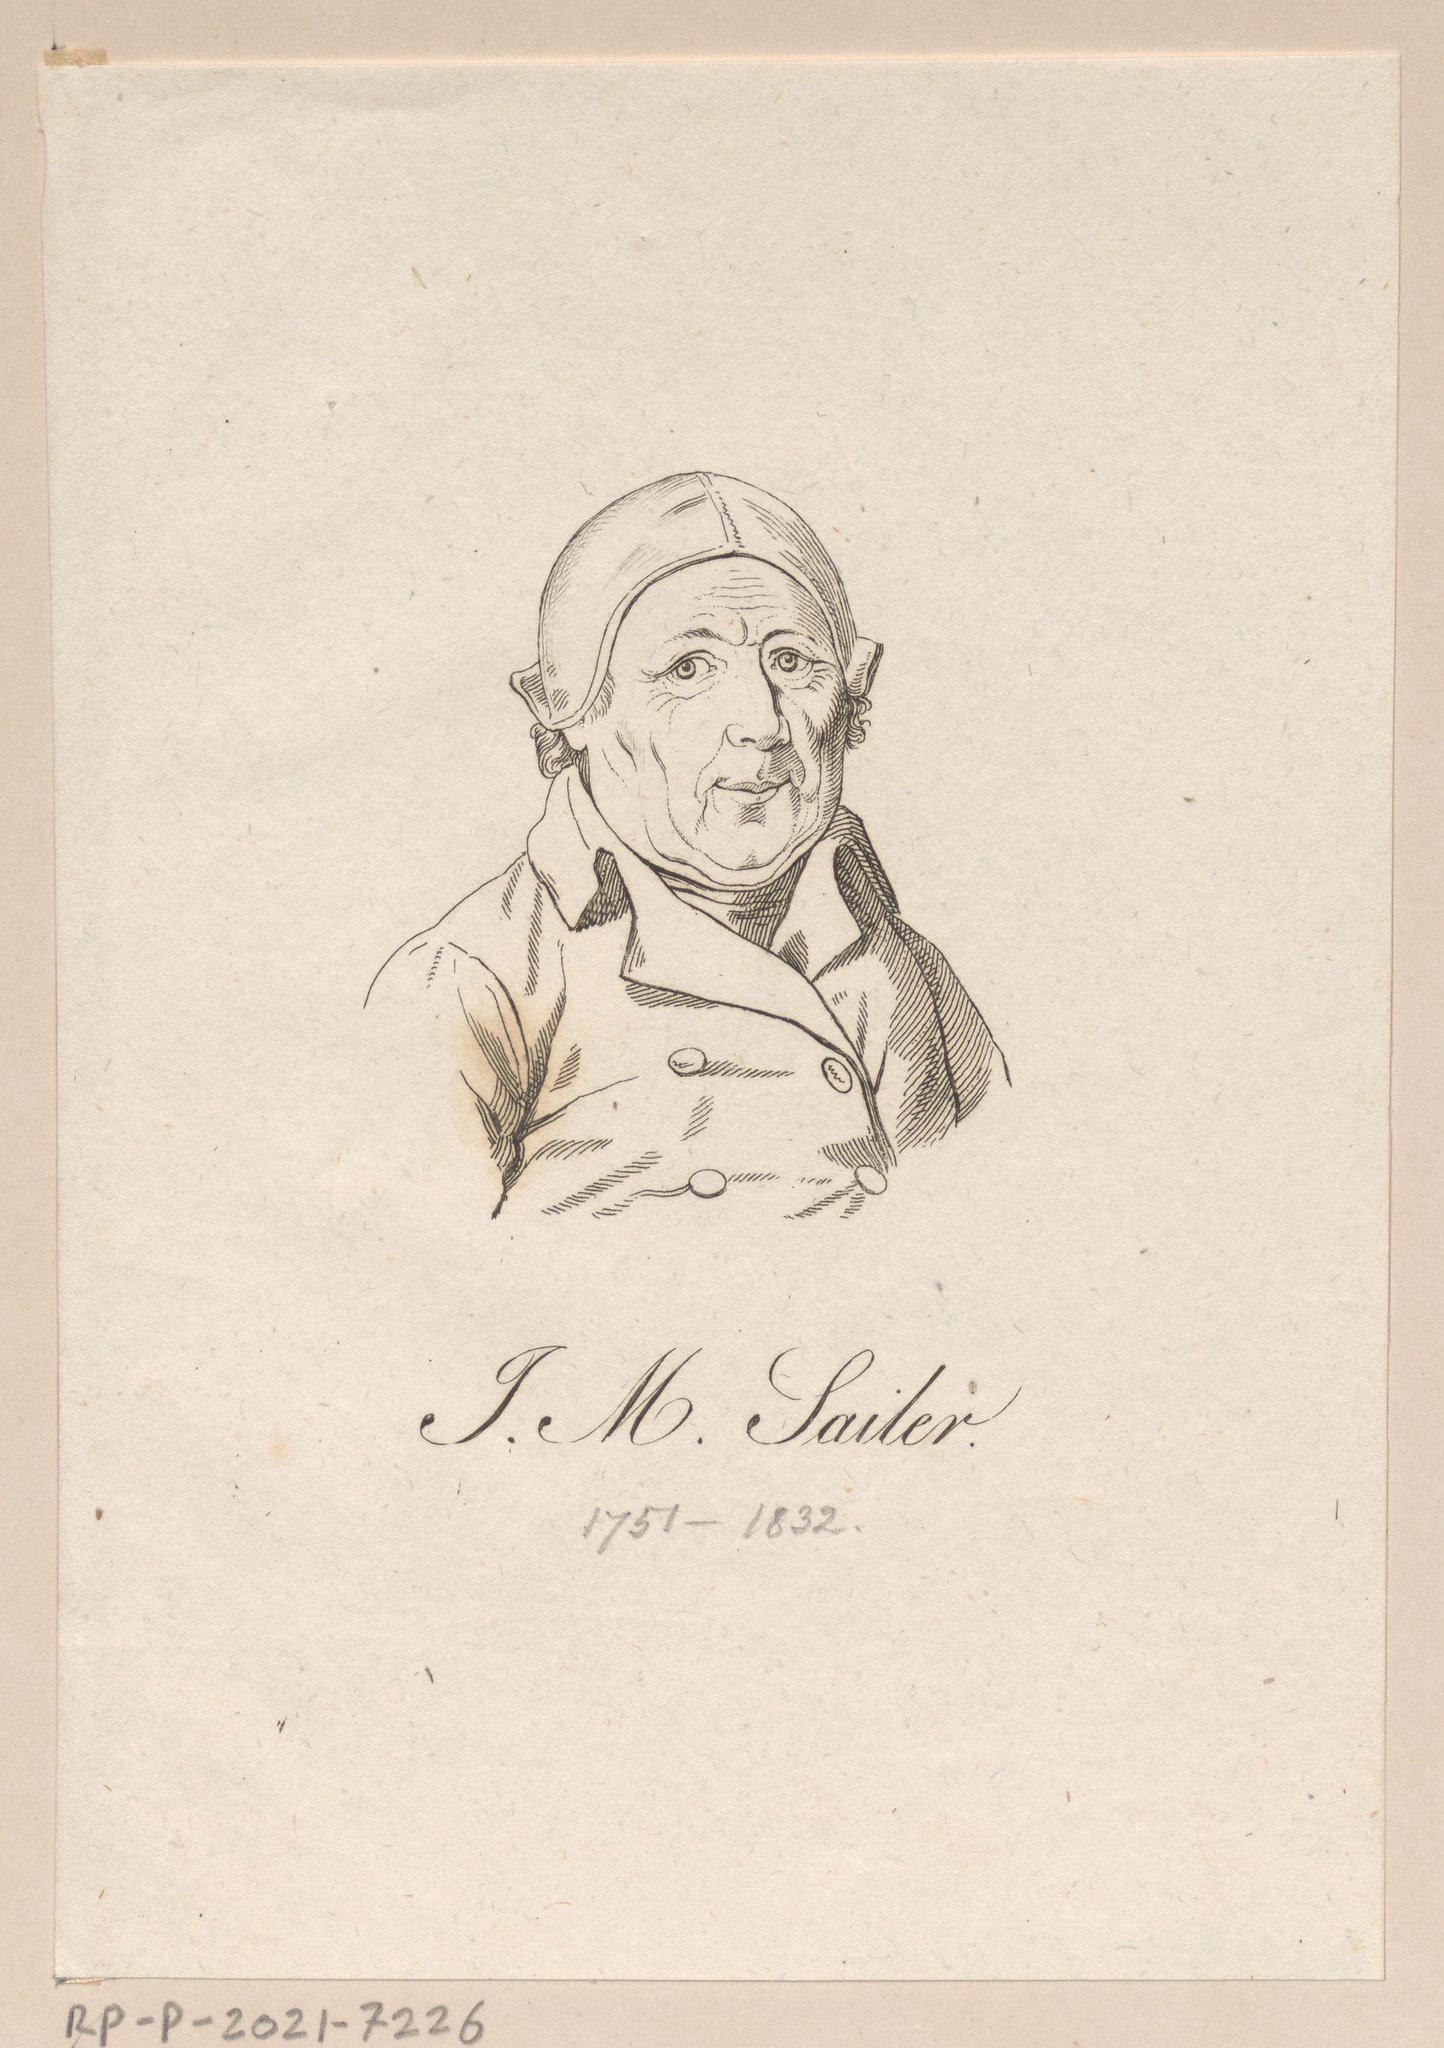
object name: print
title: Portret van Johann Michael Sailer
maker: Anonymous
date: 1770-1822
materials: paper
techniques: etching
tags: archbishop, bishop, etc. (roman catholic), historical persons